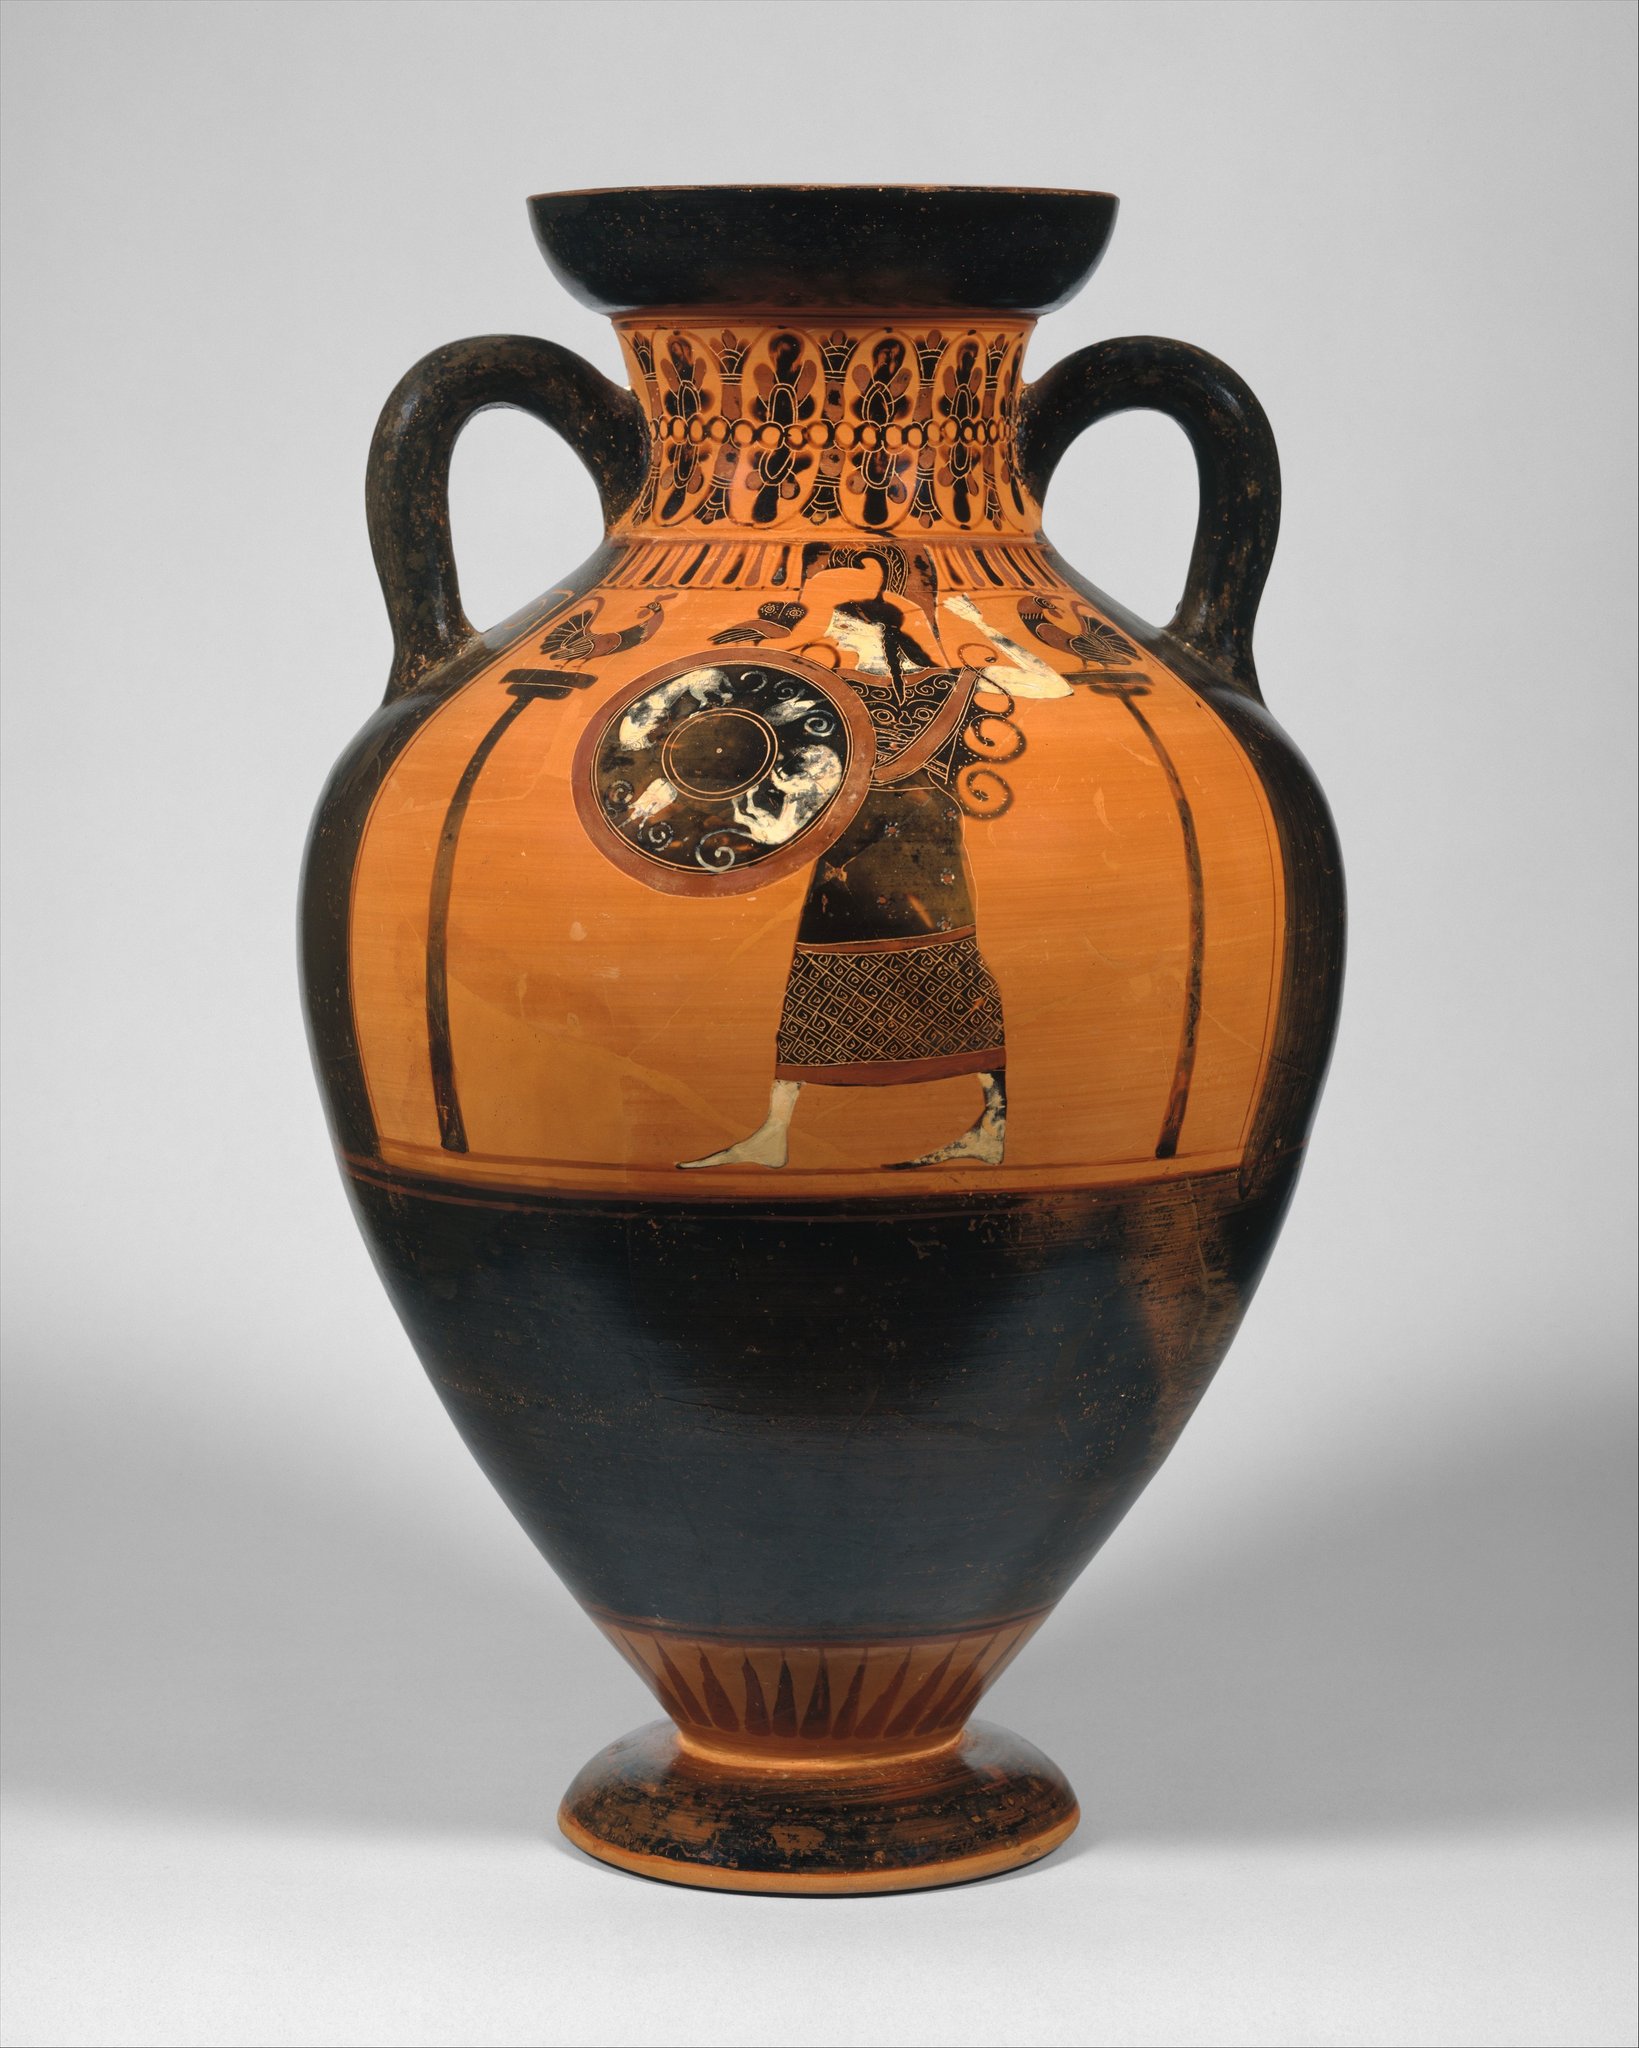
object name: neck amphora of panathenaic shape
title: Terracotta neck-amphora of Panathenaic shape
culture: greek, attic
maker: princeton painter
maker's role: artist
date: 540-530 BCE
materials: terracotta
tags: men,flutes,athena,musicians